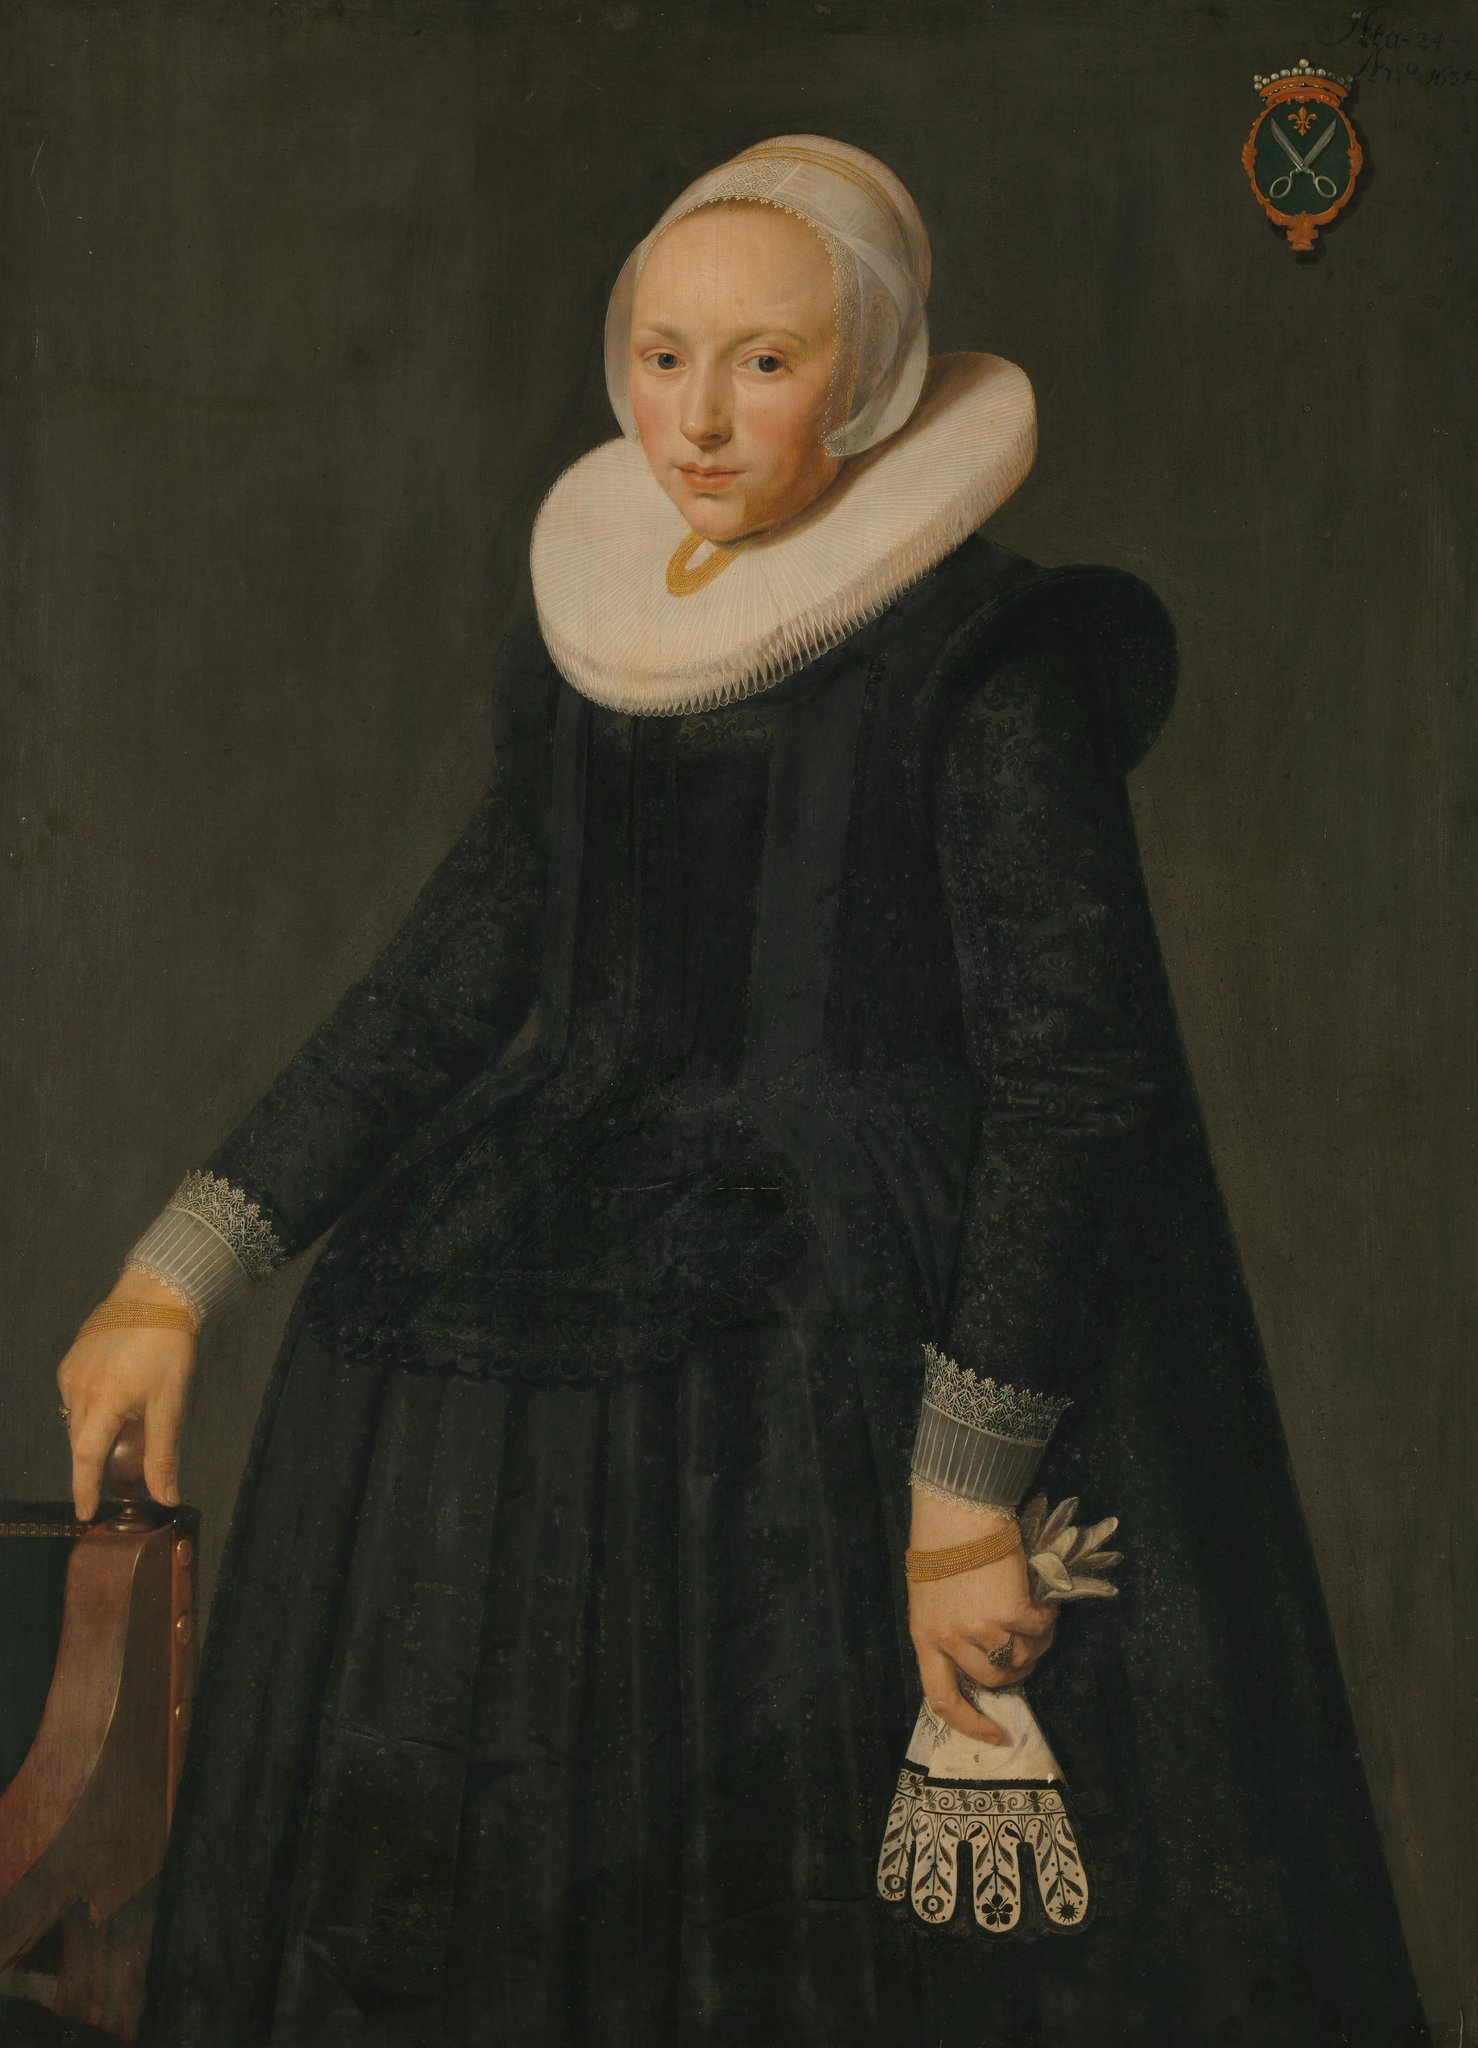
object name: painting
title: Trijntje Tijsdr van Nooy (b 1607), Wife of Reinier Ottsz Hinloopen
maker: Anonymous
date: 1631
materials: oil, panel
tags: historical persons - bb - woman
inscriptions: coat of arms, top right: silver tailor’s shears on a green ground, a red fleur-de-lis above, inscription, top right, in black paint: ‘Æta . 24 .’, date, top right: ‘Anº . 1631 .’, inscription, on the reverse: ‘Trijntijen Tijsz / Van Nooij’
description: Portret van Trijntje Tijsdr van Nooij (1606/07-1646), echtgenote van Reinier Ottsz Hinloopen. Kniestuk, staande naar links, handschoenen in de linkerhand, de rechterhand rustend op de rug van een stoel. Rechtsboven het familiewapen. Pendant van SK-A-1319.